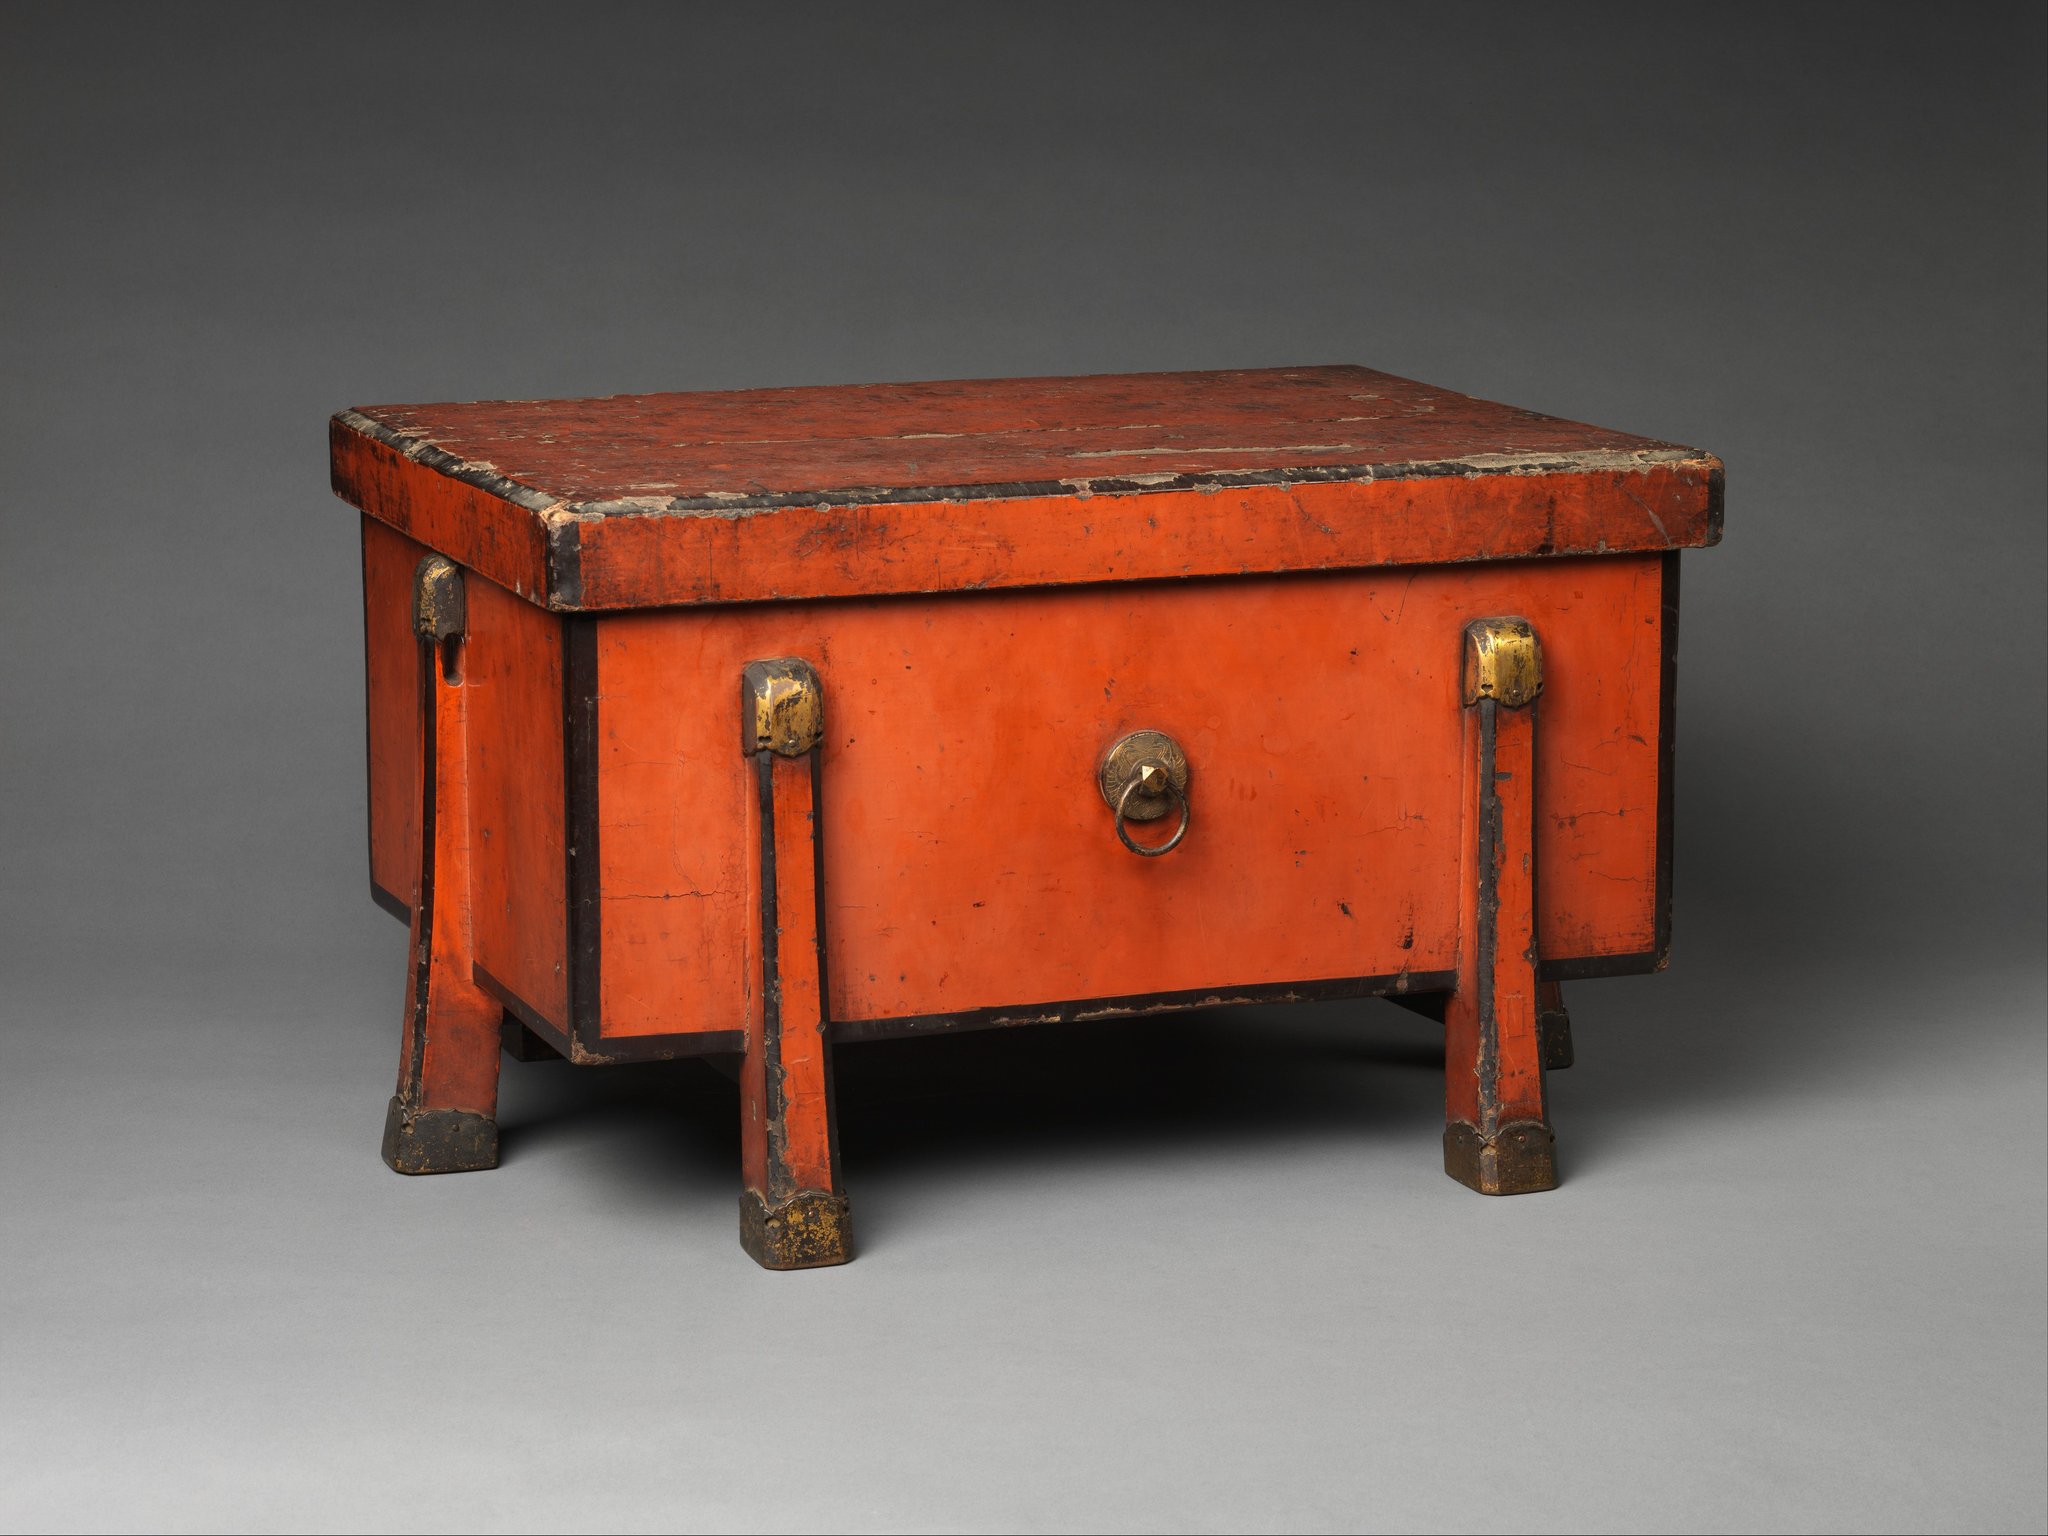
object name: storage chest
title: Storage Case (Karabitsu)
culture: japanese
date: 1422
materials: gilt bronze, lacquer, wood